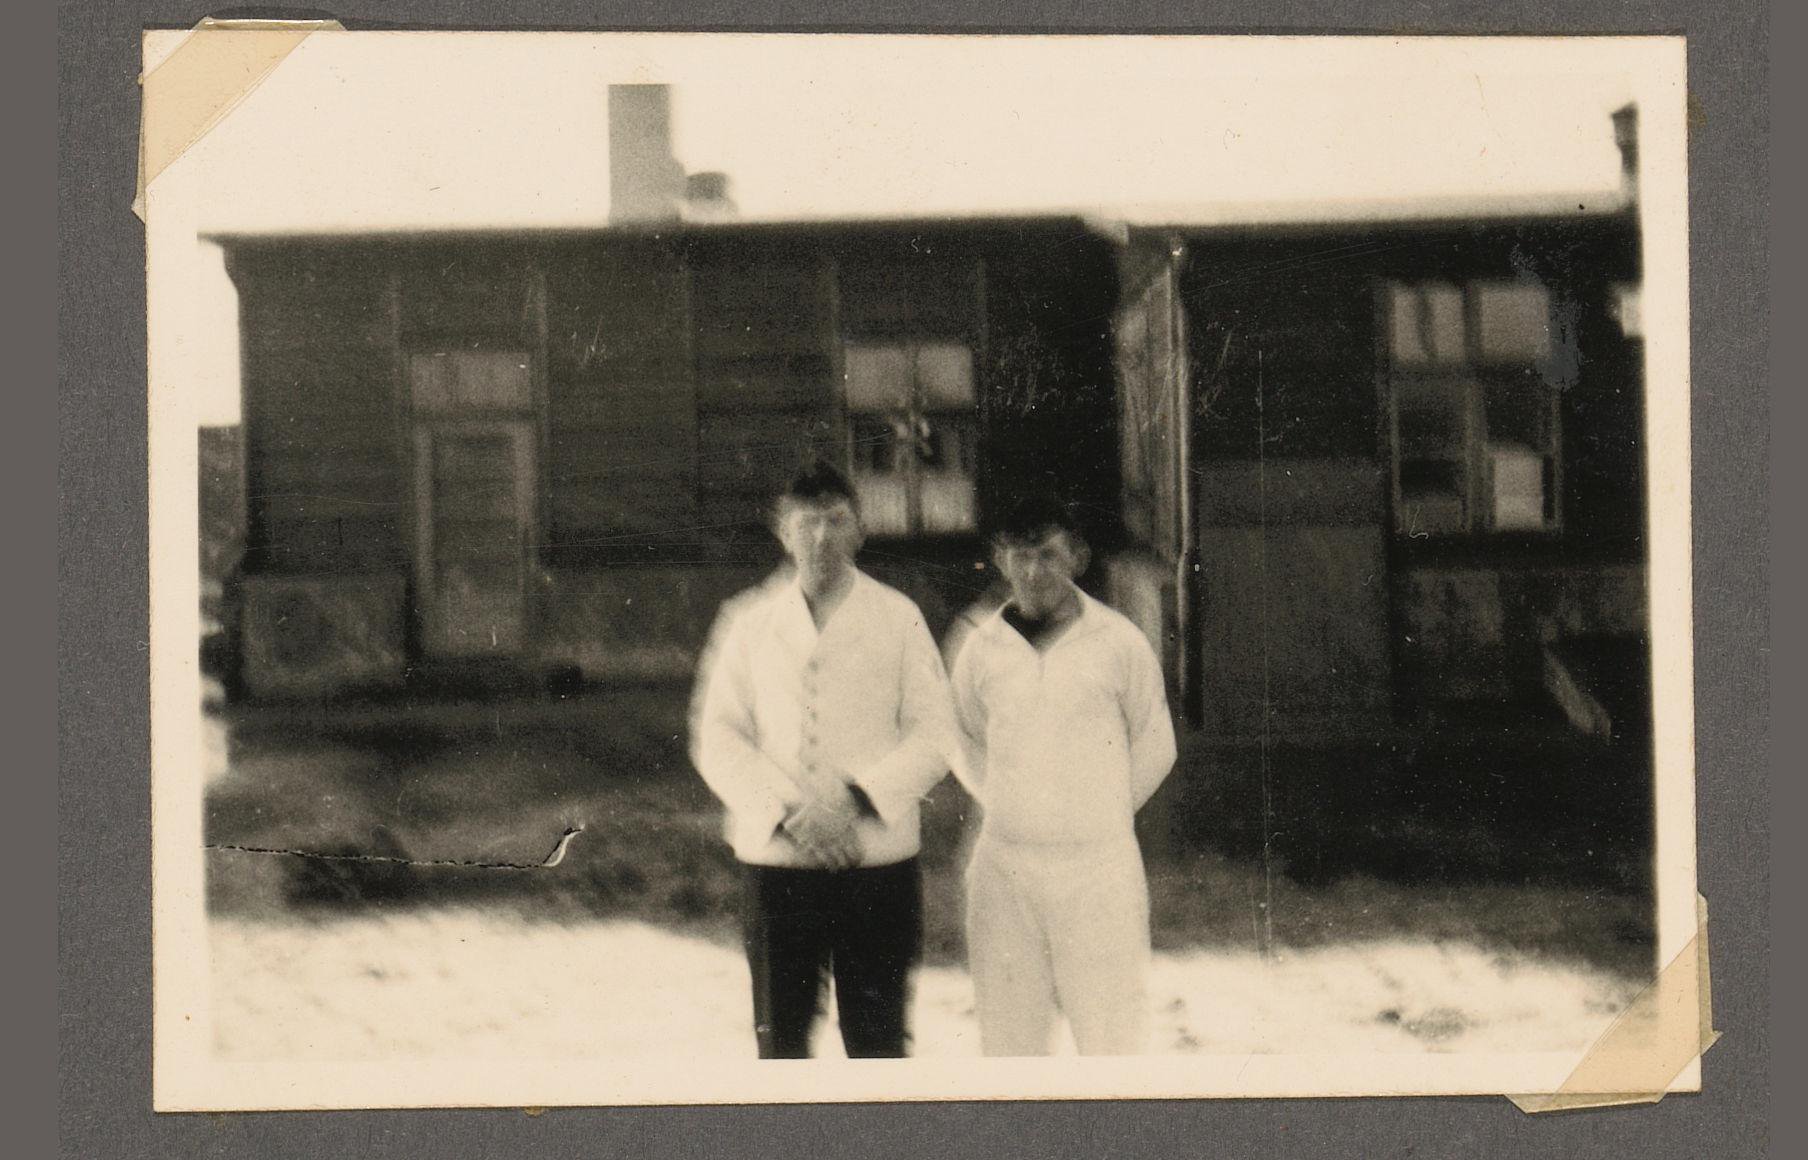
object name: photograph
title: Ob. Gfr. Drössiger en militair voor bebouwing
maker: Anonymous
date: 1941-1945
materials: paper, photographic support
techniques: gelatin silver print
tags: historical persons, the soldier; the soldier's life, civic architecture; edifices; dwellings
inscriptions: annotation: ‘Pressefotogr. W. Ulrich - 2 A.d.O.’, annotation: ‘Bstsmt Colinsee + Ob. Gfr. Drössiger’